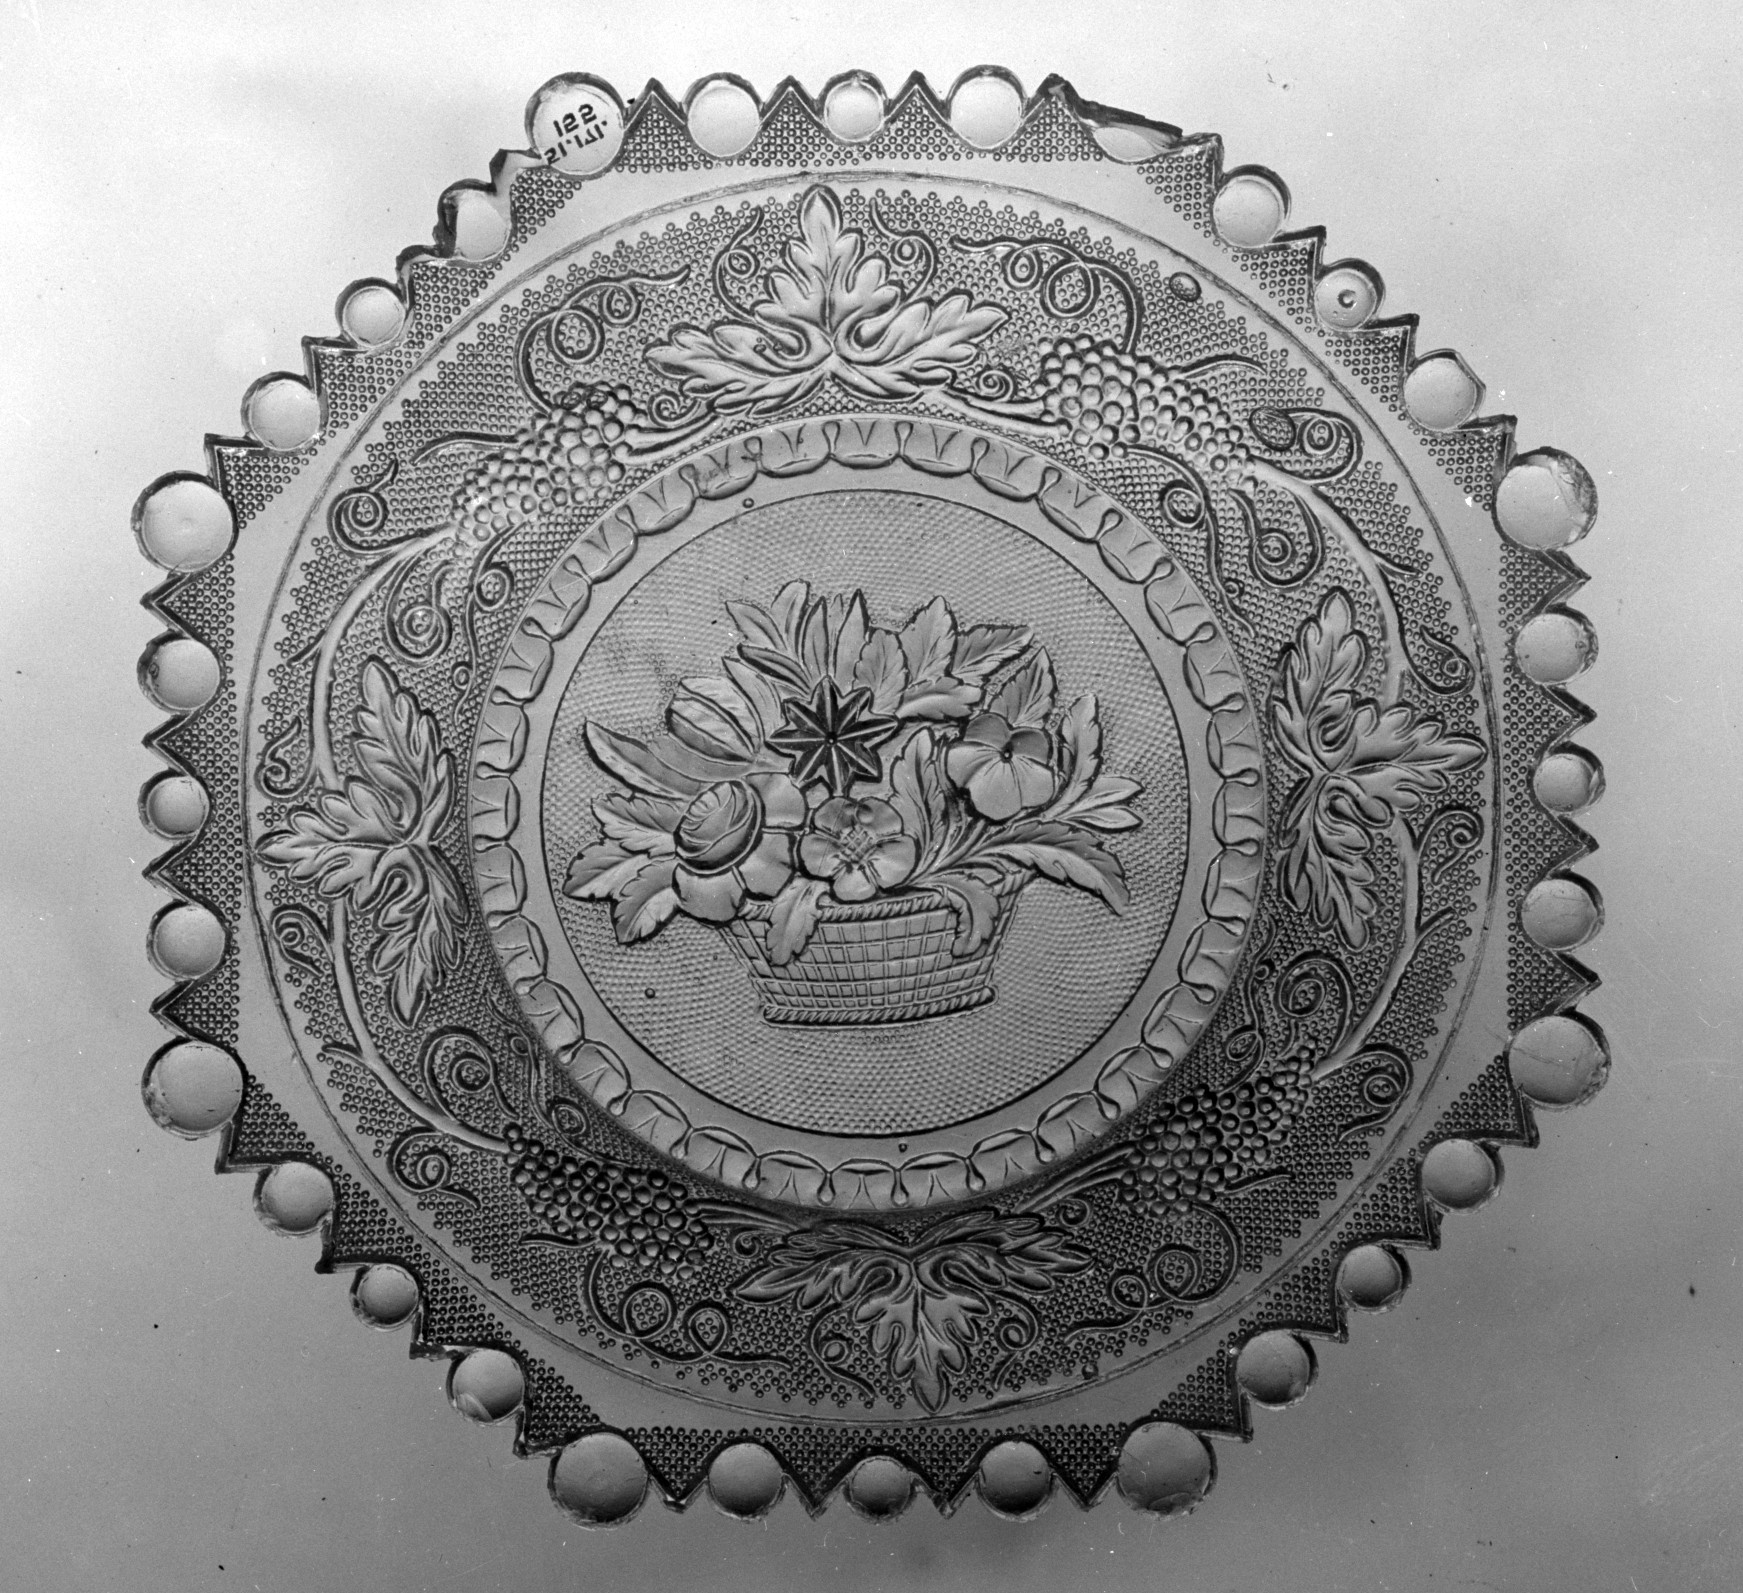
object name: plate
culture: american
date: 1830-1835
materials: glass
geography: united states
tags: flowers